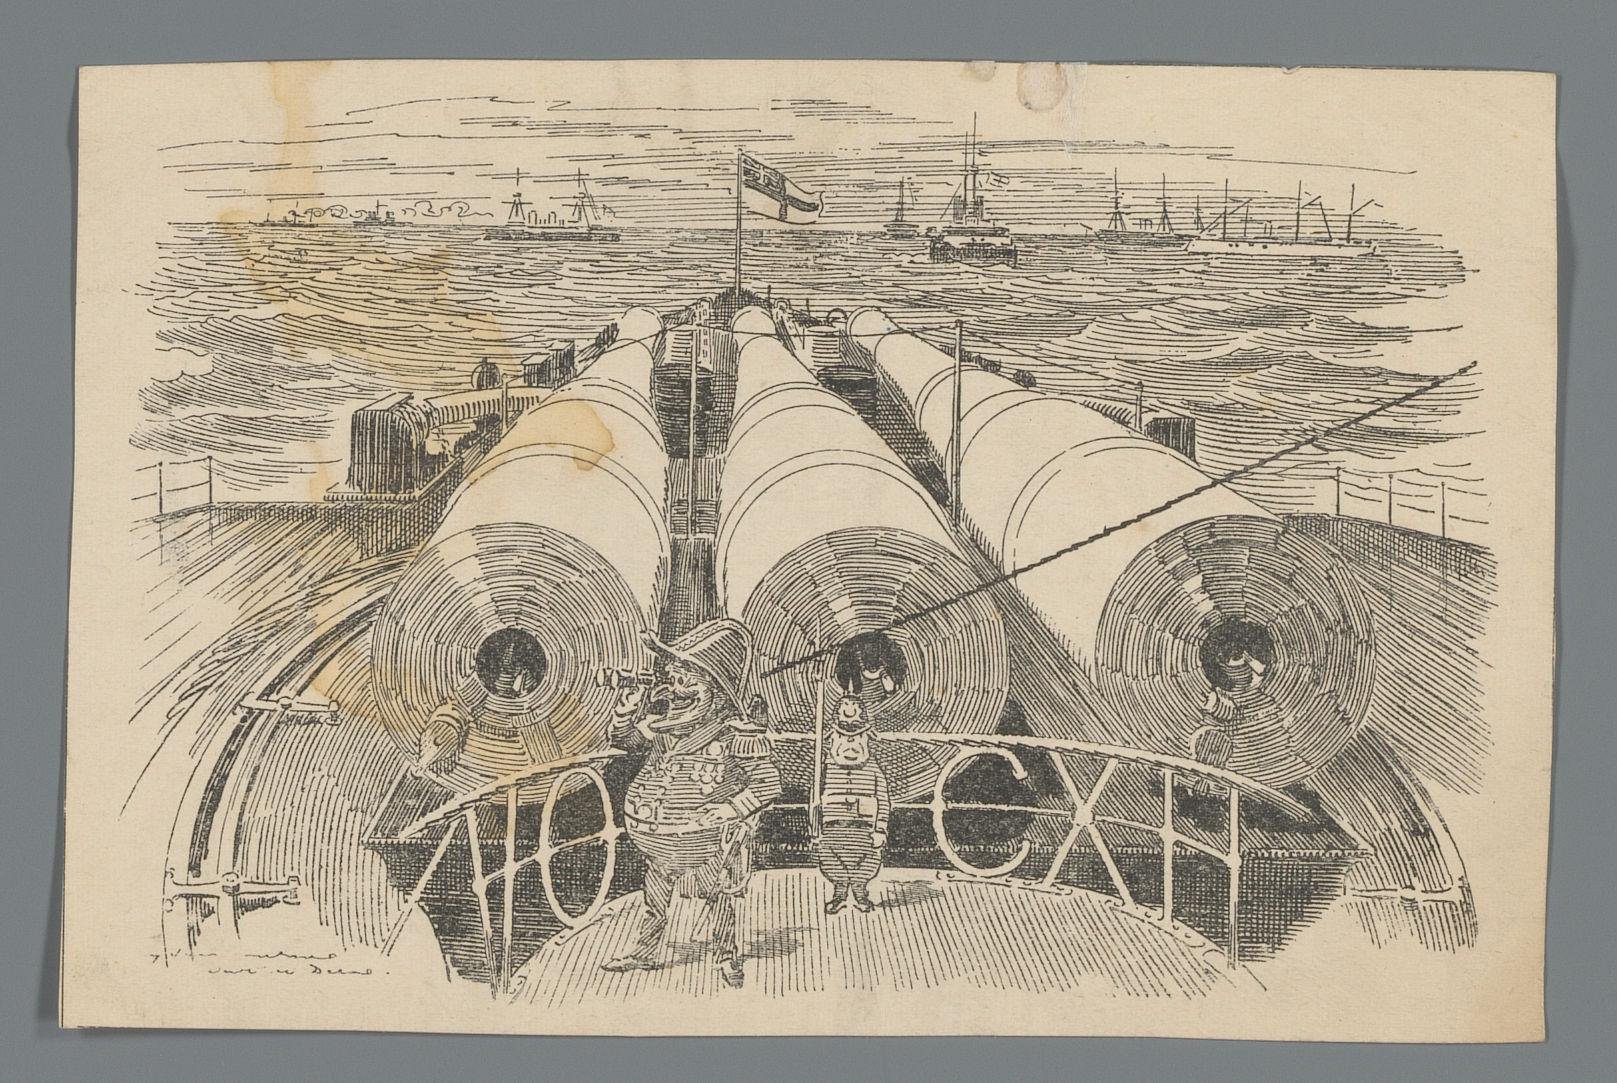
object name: print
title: Vignet uit Punch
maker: edward linley sambourne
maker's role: draughtsman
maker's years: 1844-1910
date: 1897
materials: paper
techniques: line block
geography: england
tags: warfare; military affairs (+ motor ships), political caricatures and satires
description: Mr Punch op het dek van een slagschip met drie kanonnen. Vignet uit het Engelse satirische tijdschrift Punch, vol. 112, 1897.